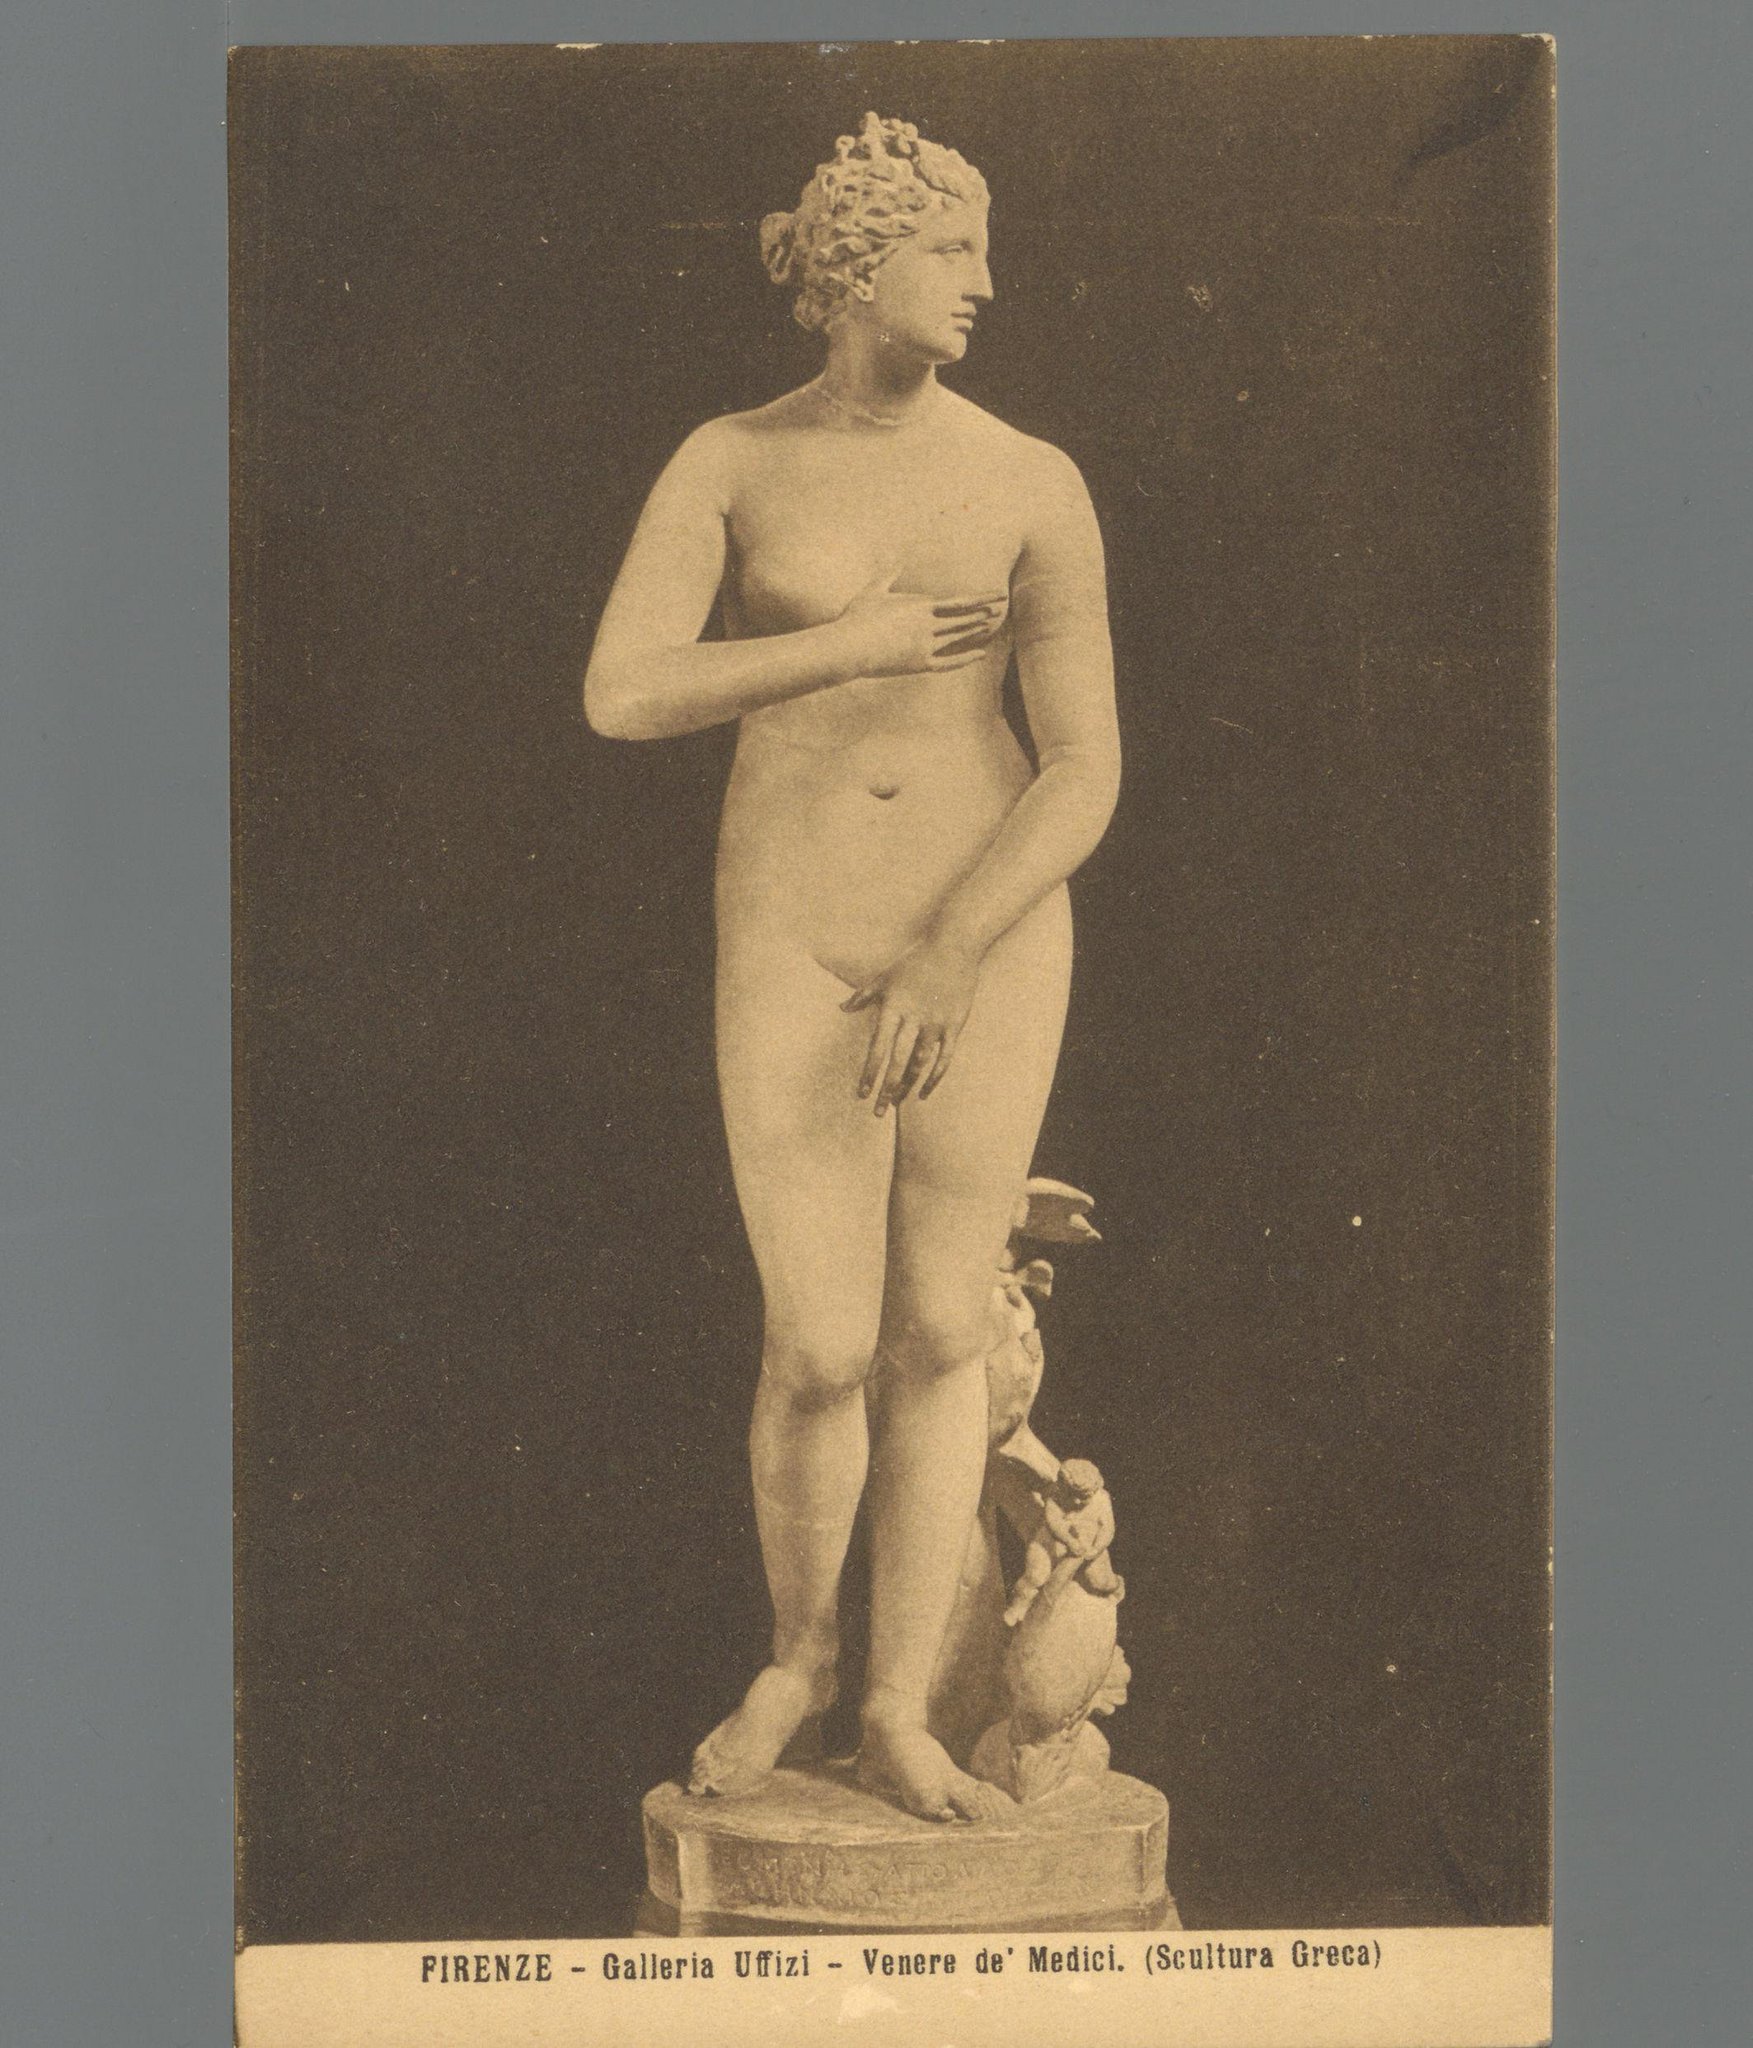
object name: photomechanical print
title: Firenze - Galleria Uffizi - Venere de'Medici (Scultura Greca)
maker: Anonymous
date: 1906-1930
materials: cardboard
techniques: photograph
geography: florence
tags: statues, paintings, etc. ~ objects of worship in greek religion, permanent exhibition, museum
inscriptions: collector's mark: ‘AFE v S’